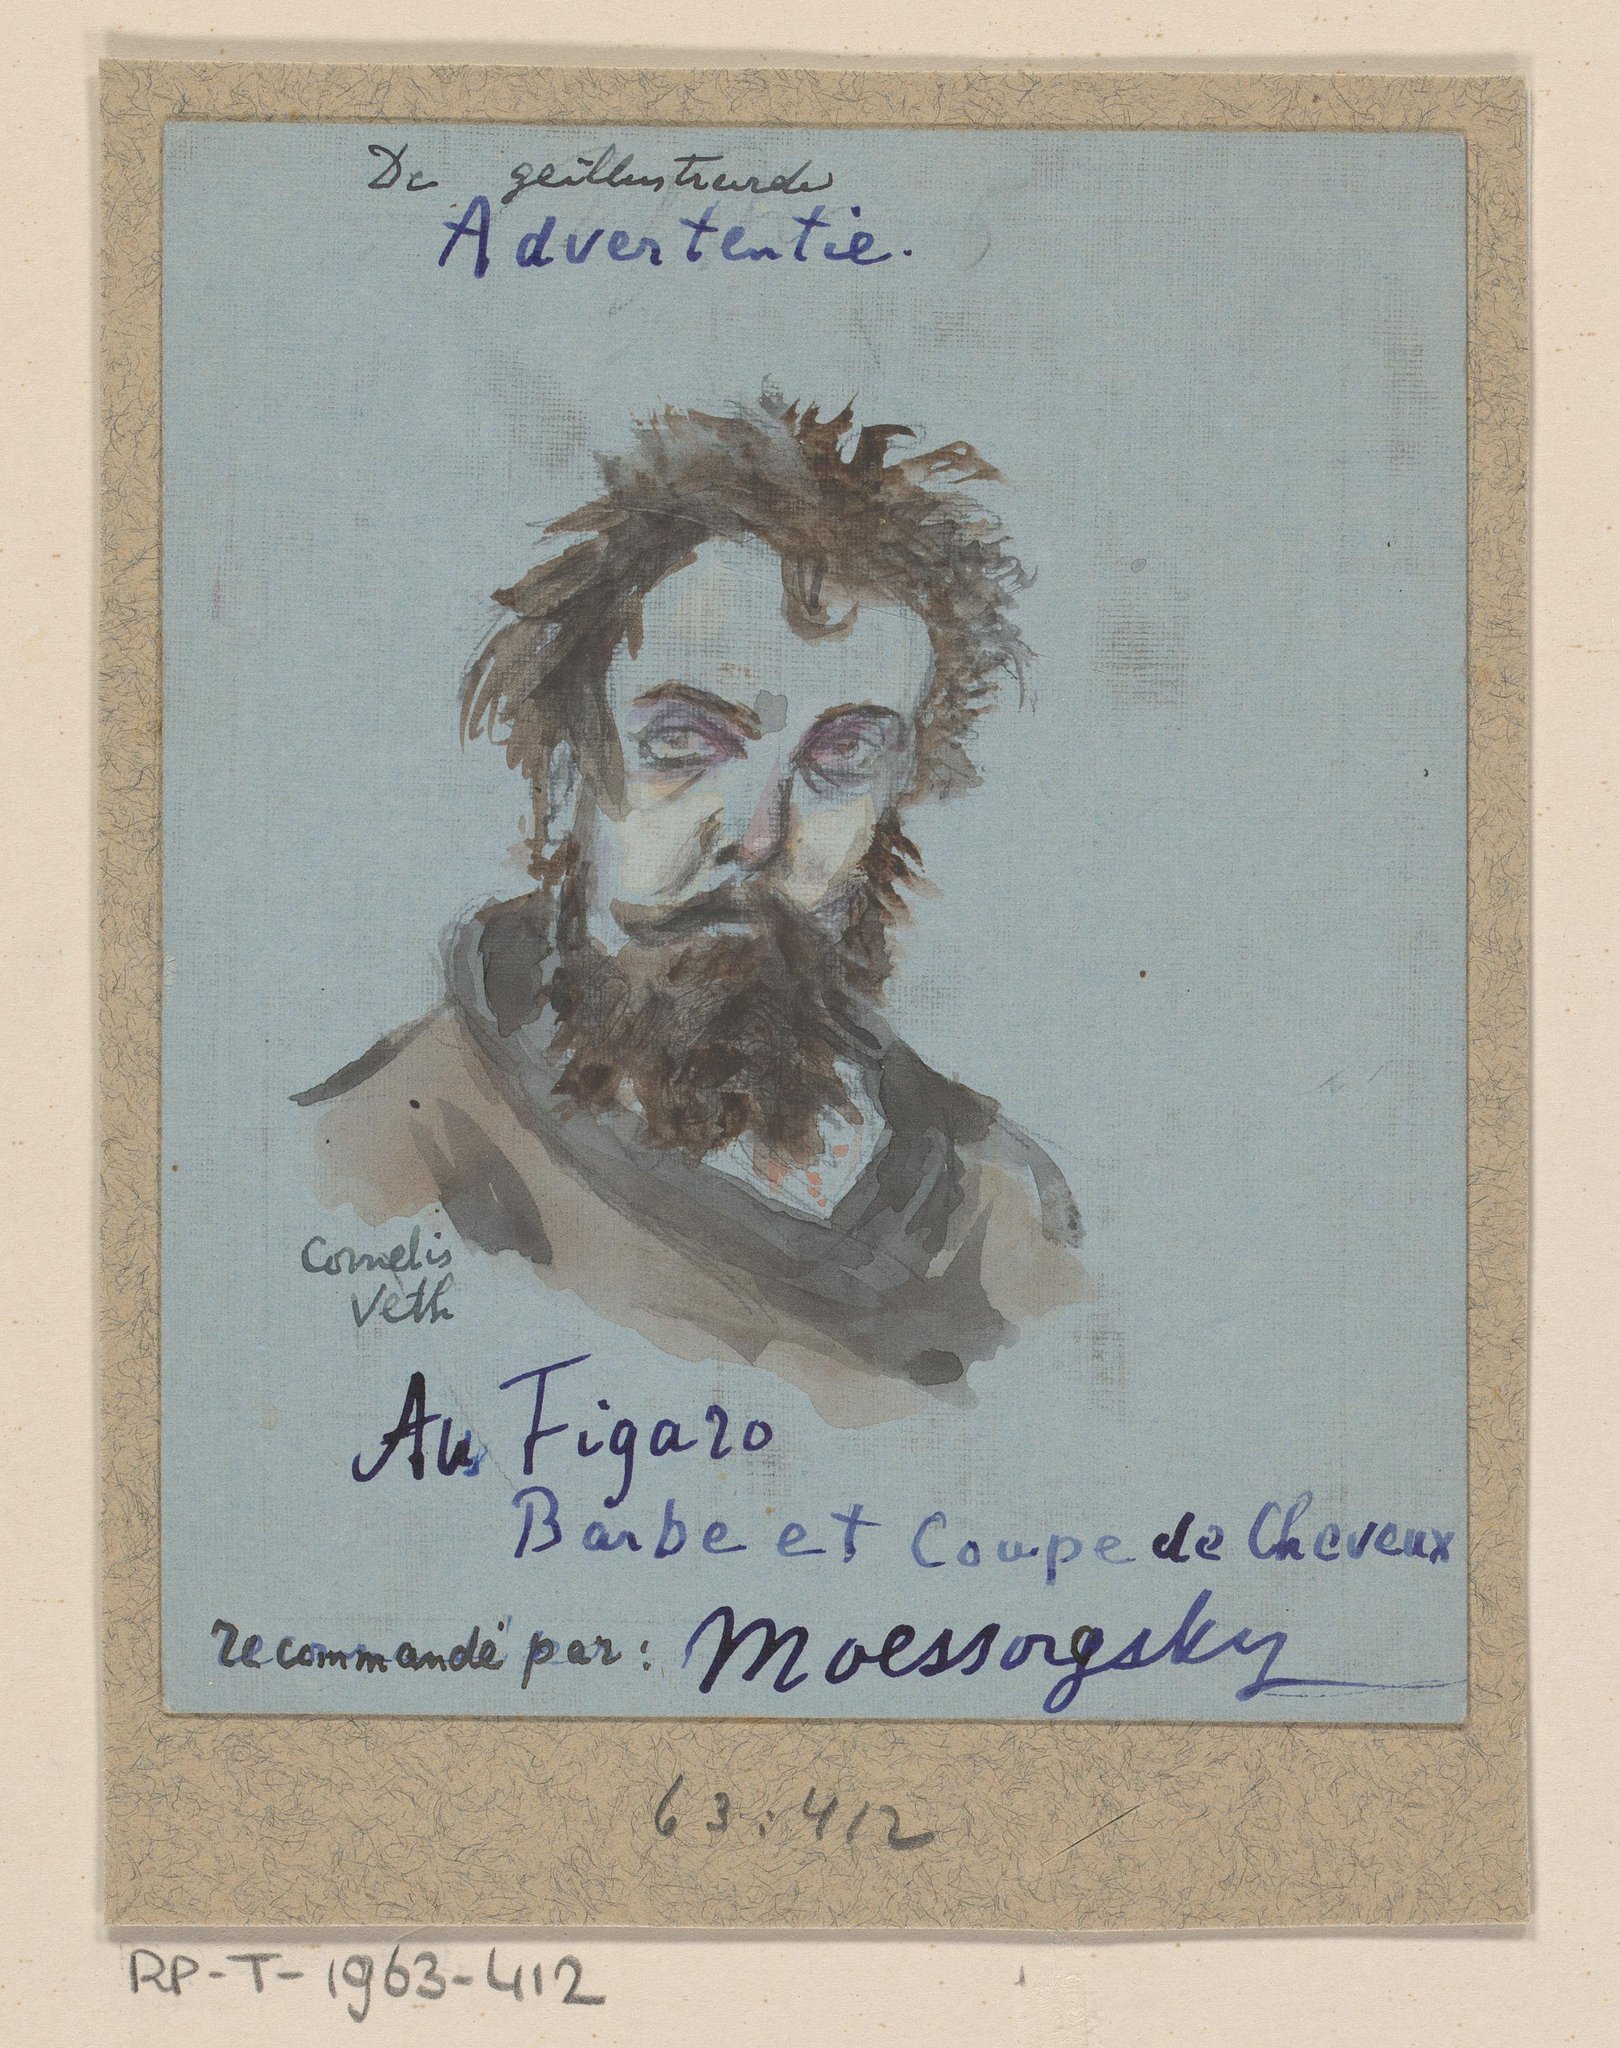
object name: drawing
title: Portret van Modest Moessorgski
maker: cornelis veth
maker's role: draughtsman, print maker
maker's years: 1880-1962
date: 1937-1939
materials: chalk, ink, paper, pencil, watercolor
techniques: brush, pen, snipping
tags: historical persons, portrait of composer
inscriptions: signature: ‘Cornelis / Veth’, inscription: ‘De geillustreerde / Advertentie. / Au Figaro / Barbe et Coupe de Cheveux / recommandé par : Moessorgsky’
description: De tekening is een voorstudie voor de uiteindelijke advertentie in: Kroniek van hedendaagsche kunst en kultuur 5 (1939).